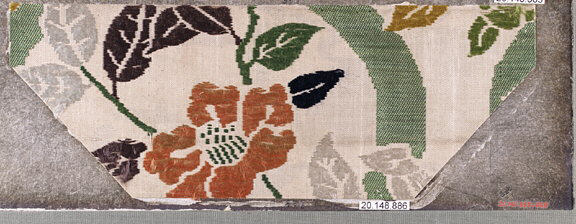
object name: piece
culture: chinese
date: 1601-1700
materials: silk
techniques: compound weave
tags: flowers,leaves